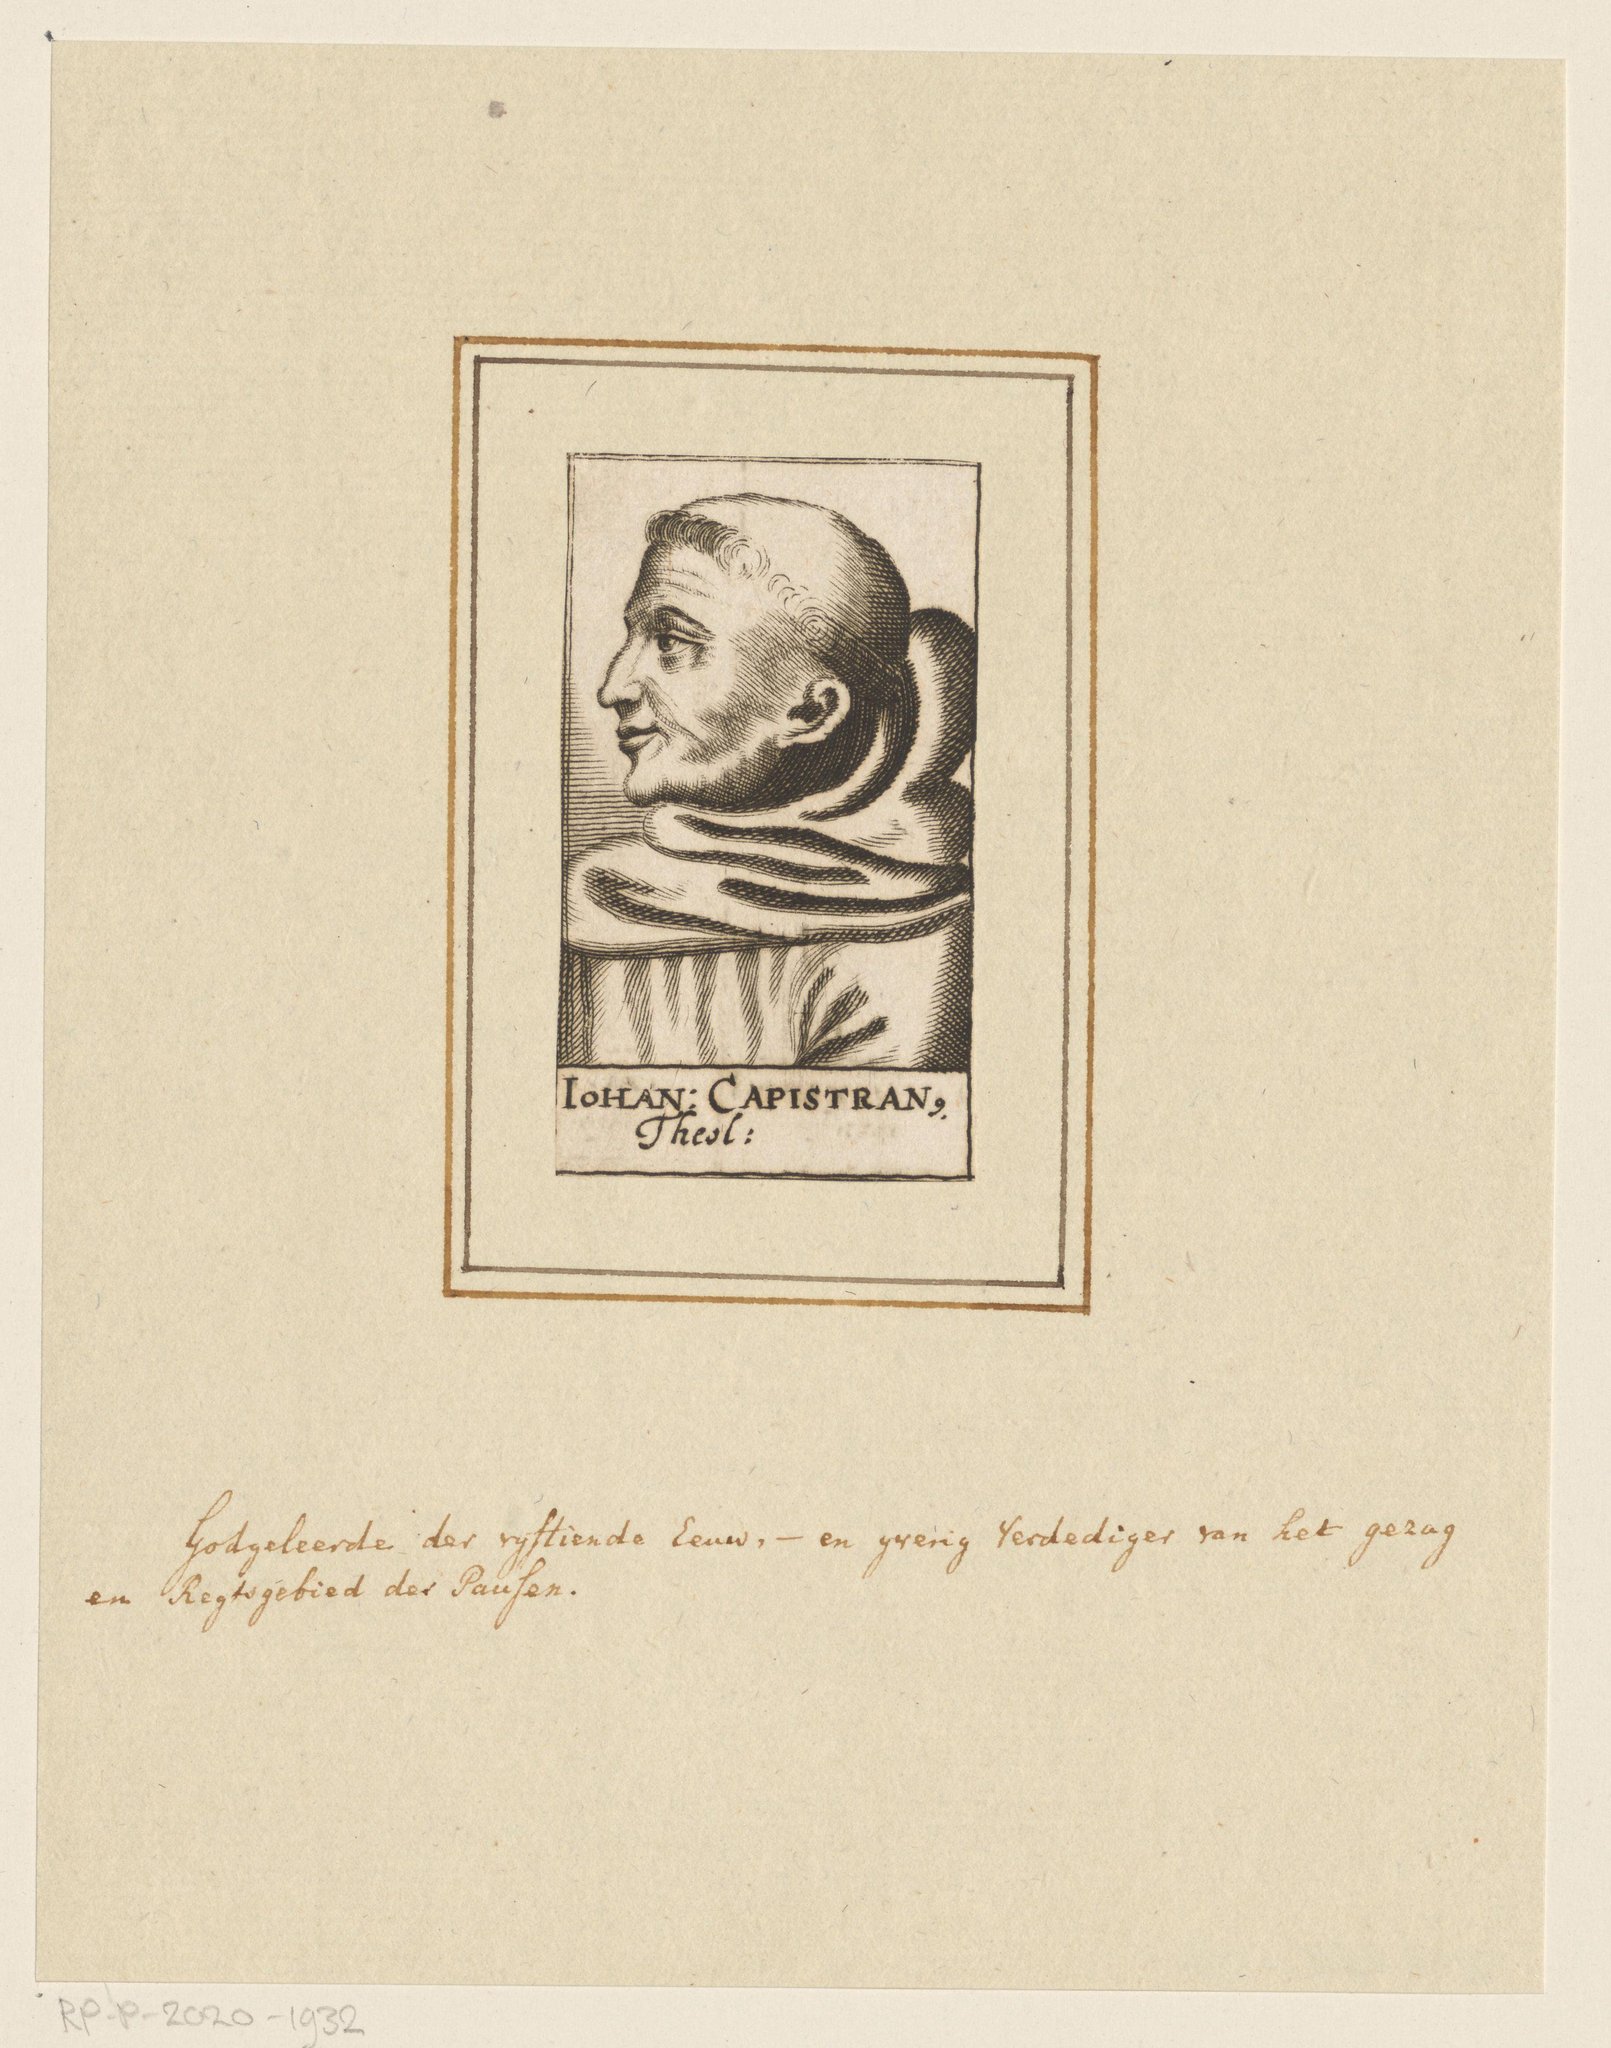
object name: book illustration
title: Portret van Johannes Capistranus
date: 1688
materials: paper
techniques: engraving, etching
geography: nuremberg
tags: historical persons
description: Prent uit: Freher, Paul. Theatrum virorum eruditione clarorum. Neurenberg: Johann Hoffmann, 1688.